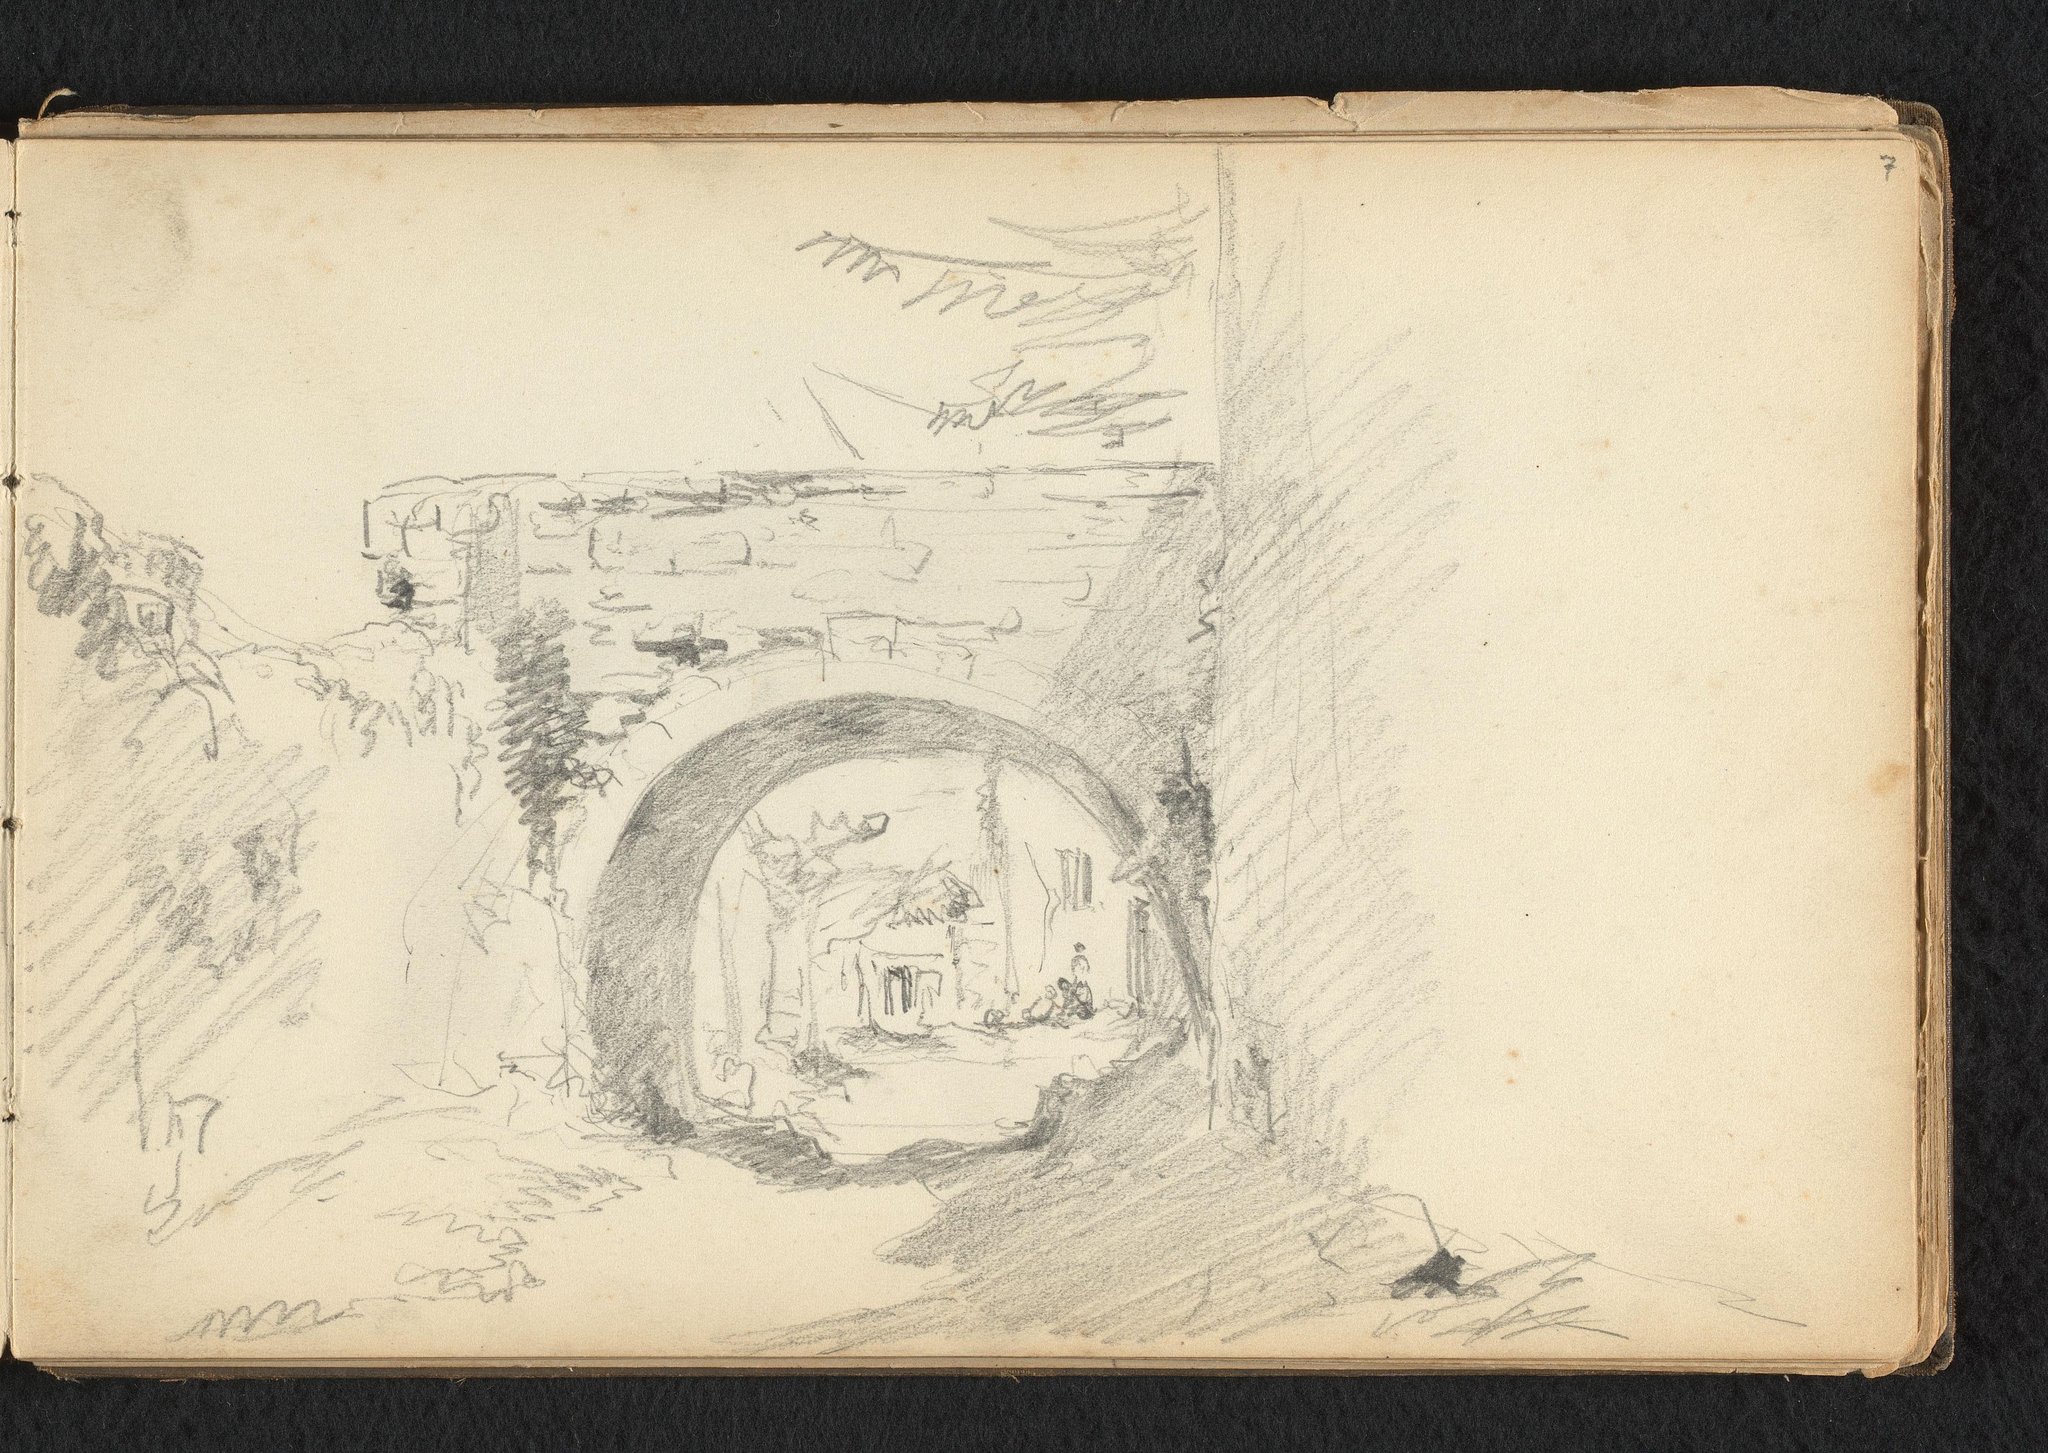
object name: sketchbook leaf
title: Landschap met brug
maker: jan bedijs tom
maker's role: draughtsman, painter, print maker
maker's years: 1813-1894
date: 1823-1894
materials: paper, pencil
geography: the hague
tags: bridge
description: Pagina 7 recto uit een schetsboek met 37 bladen.